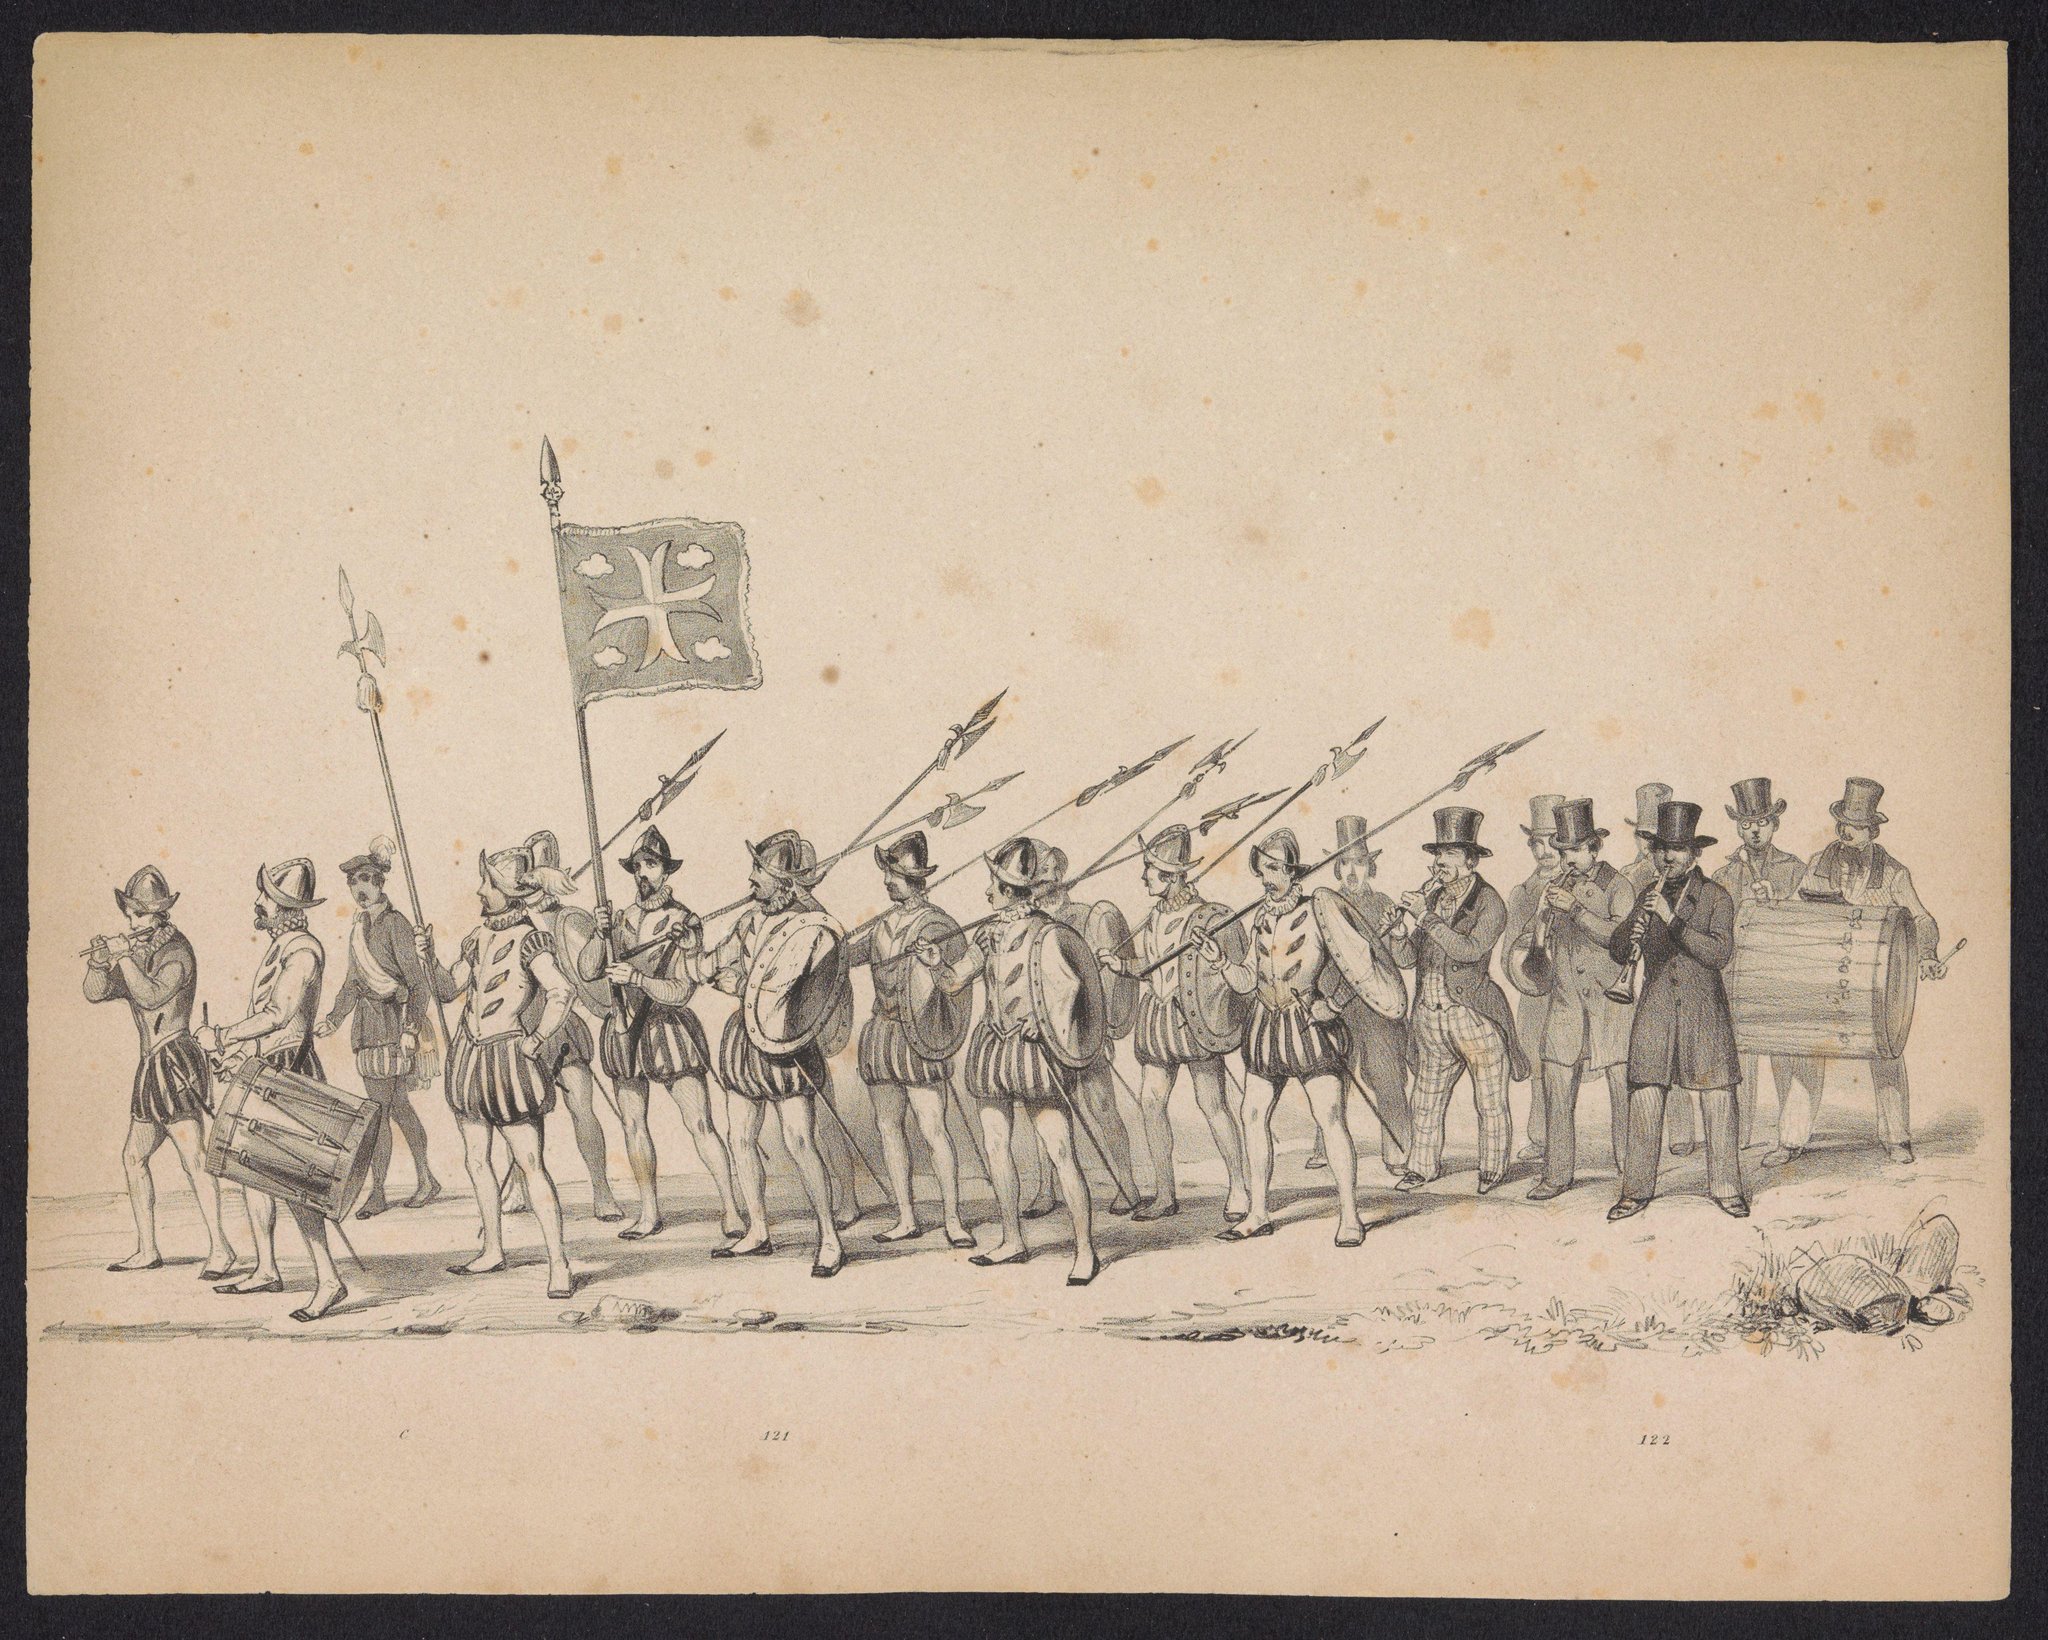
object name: print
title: Afbeelding van den gecostumeerden optogt, voorstellende den in togt van Philips II, Prins van Spanje, in Utrecht, den 3en October 1549, gehouden den 17en Junij 1846, door H.H. Studenten der Utrechtsche Hoogeschool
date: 1847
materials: paper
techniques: lithograph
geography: leiden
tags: philip ii of spain, students' pageant, costumes used in pageants, utrecht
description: Historische gekostumeerde optocht van de studenten van de Utrechtse Hogeschool gehouden op 17 juni 1846 ter gelegenheid van het 210-jarig bestaan van de Hogeschool. De optocht verbeeldt de intocht van Filips II in Utrecht op 3 oktober 1549. Plaat met de groepen genummerd 121-122. Onderdeel van de serie van 22 aanelkaar te plakken losse bladen.